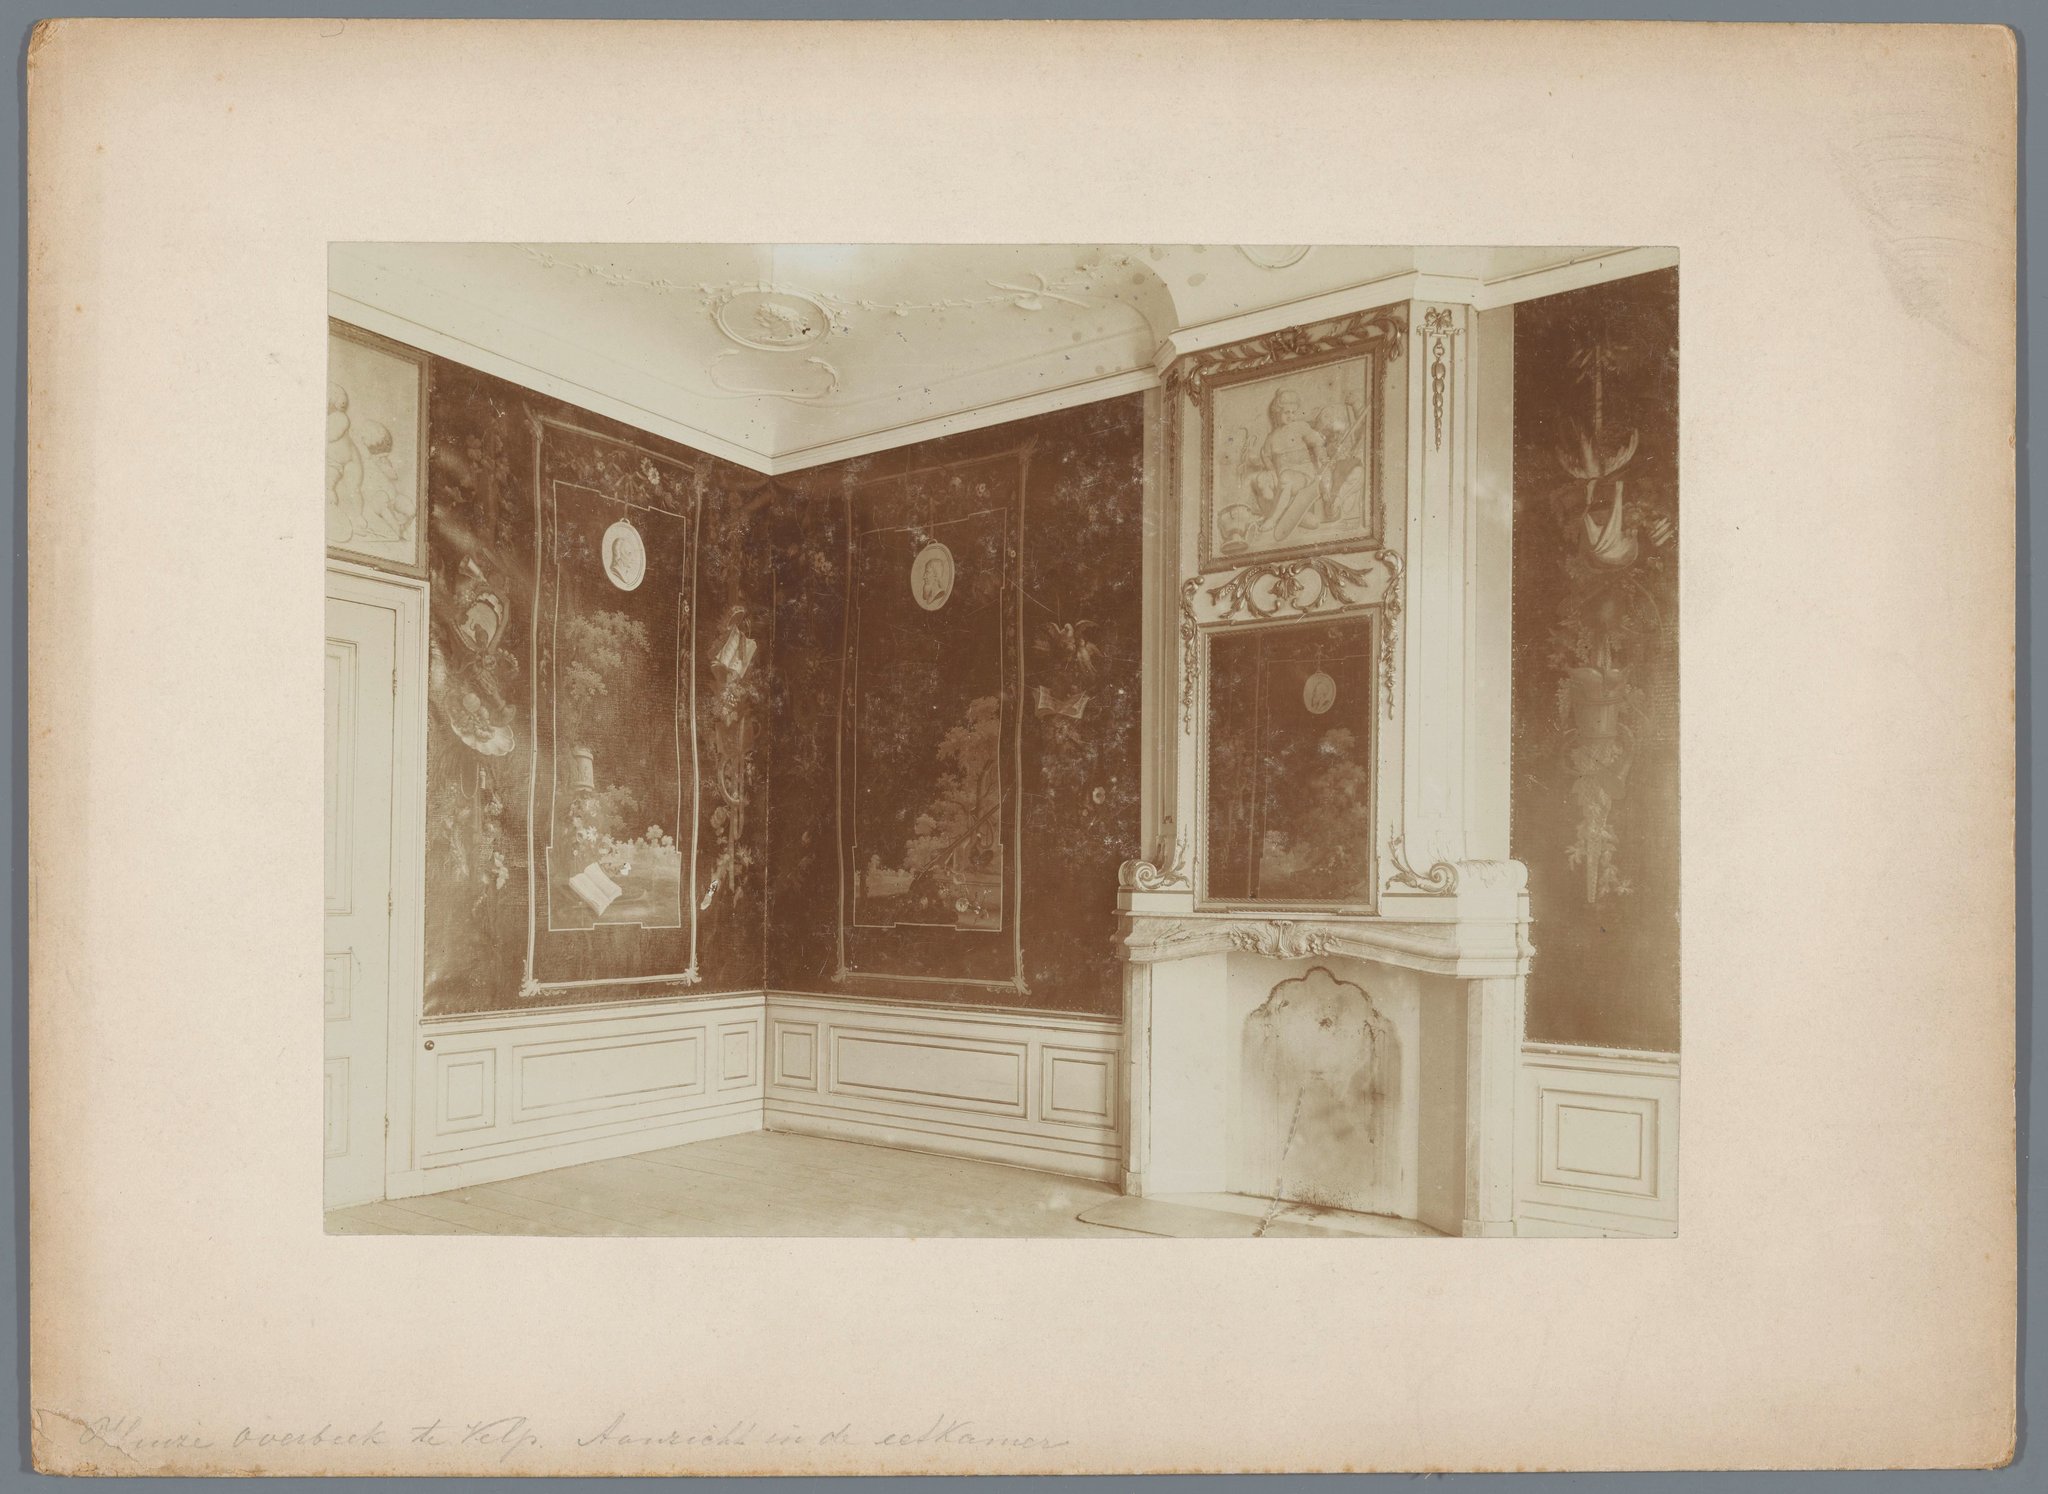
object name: photograph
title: Interieur van de eetkamer in Huize Overbeek te Velp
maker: Anonymous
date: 1903-1906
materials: cardboard, photographic support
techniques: collodion silver print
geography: velp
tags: open hearth, fire-place, interior ~ representation of a building, dining-room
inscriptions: annotation, inscription: ‘neg. no 16841 foto no 23913’, inscription: ‘Huize Overbeek te Velp. Aanzicht in de eetkamer’